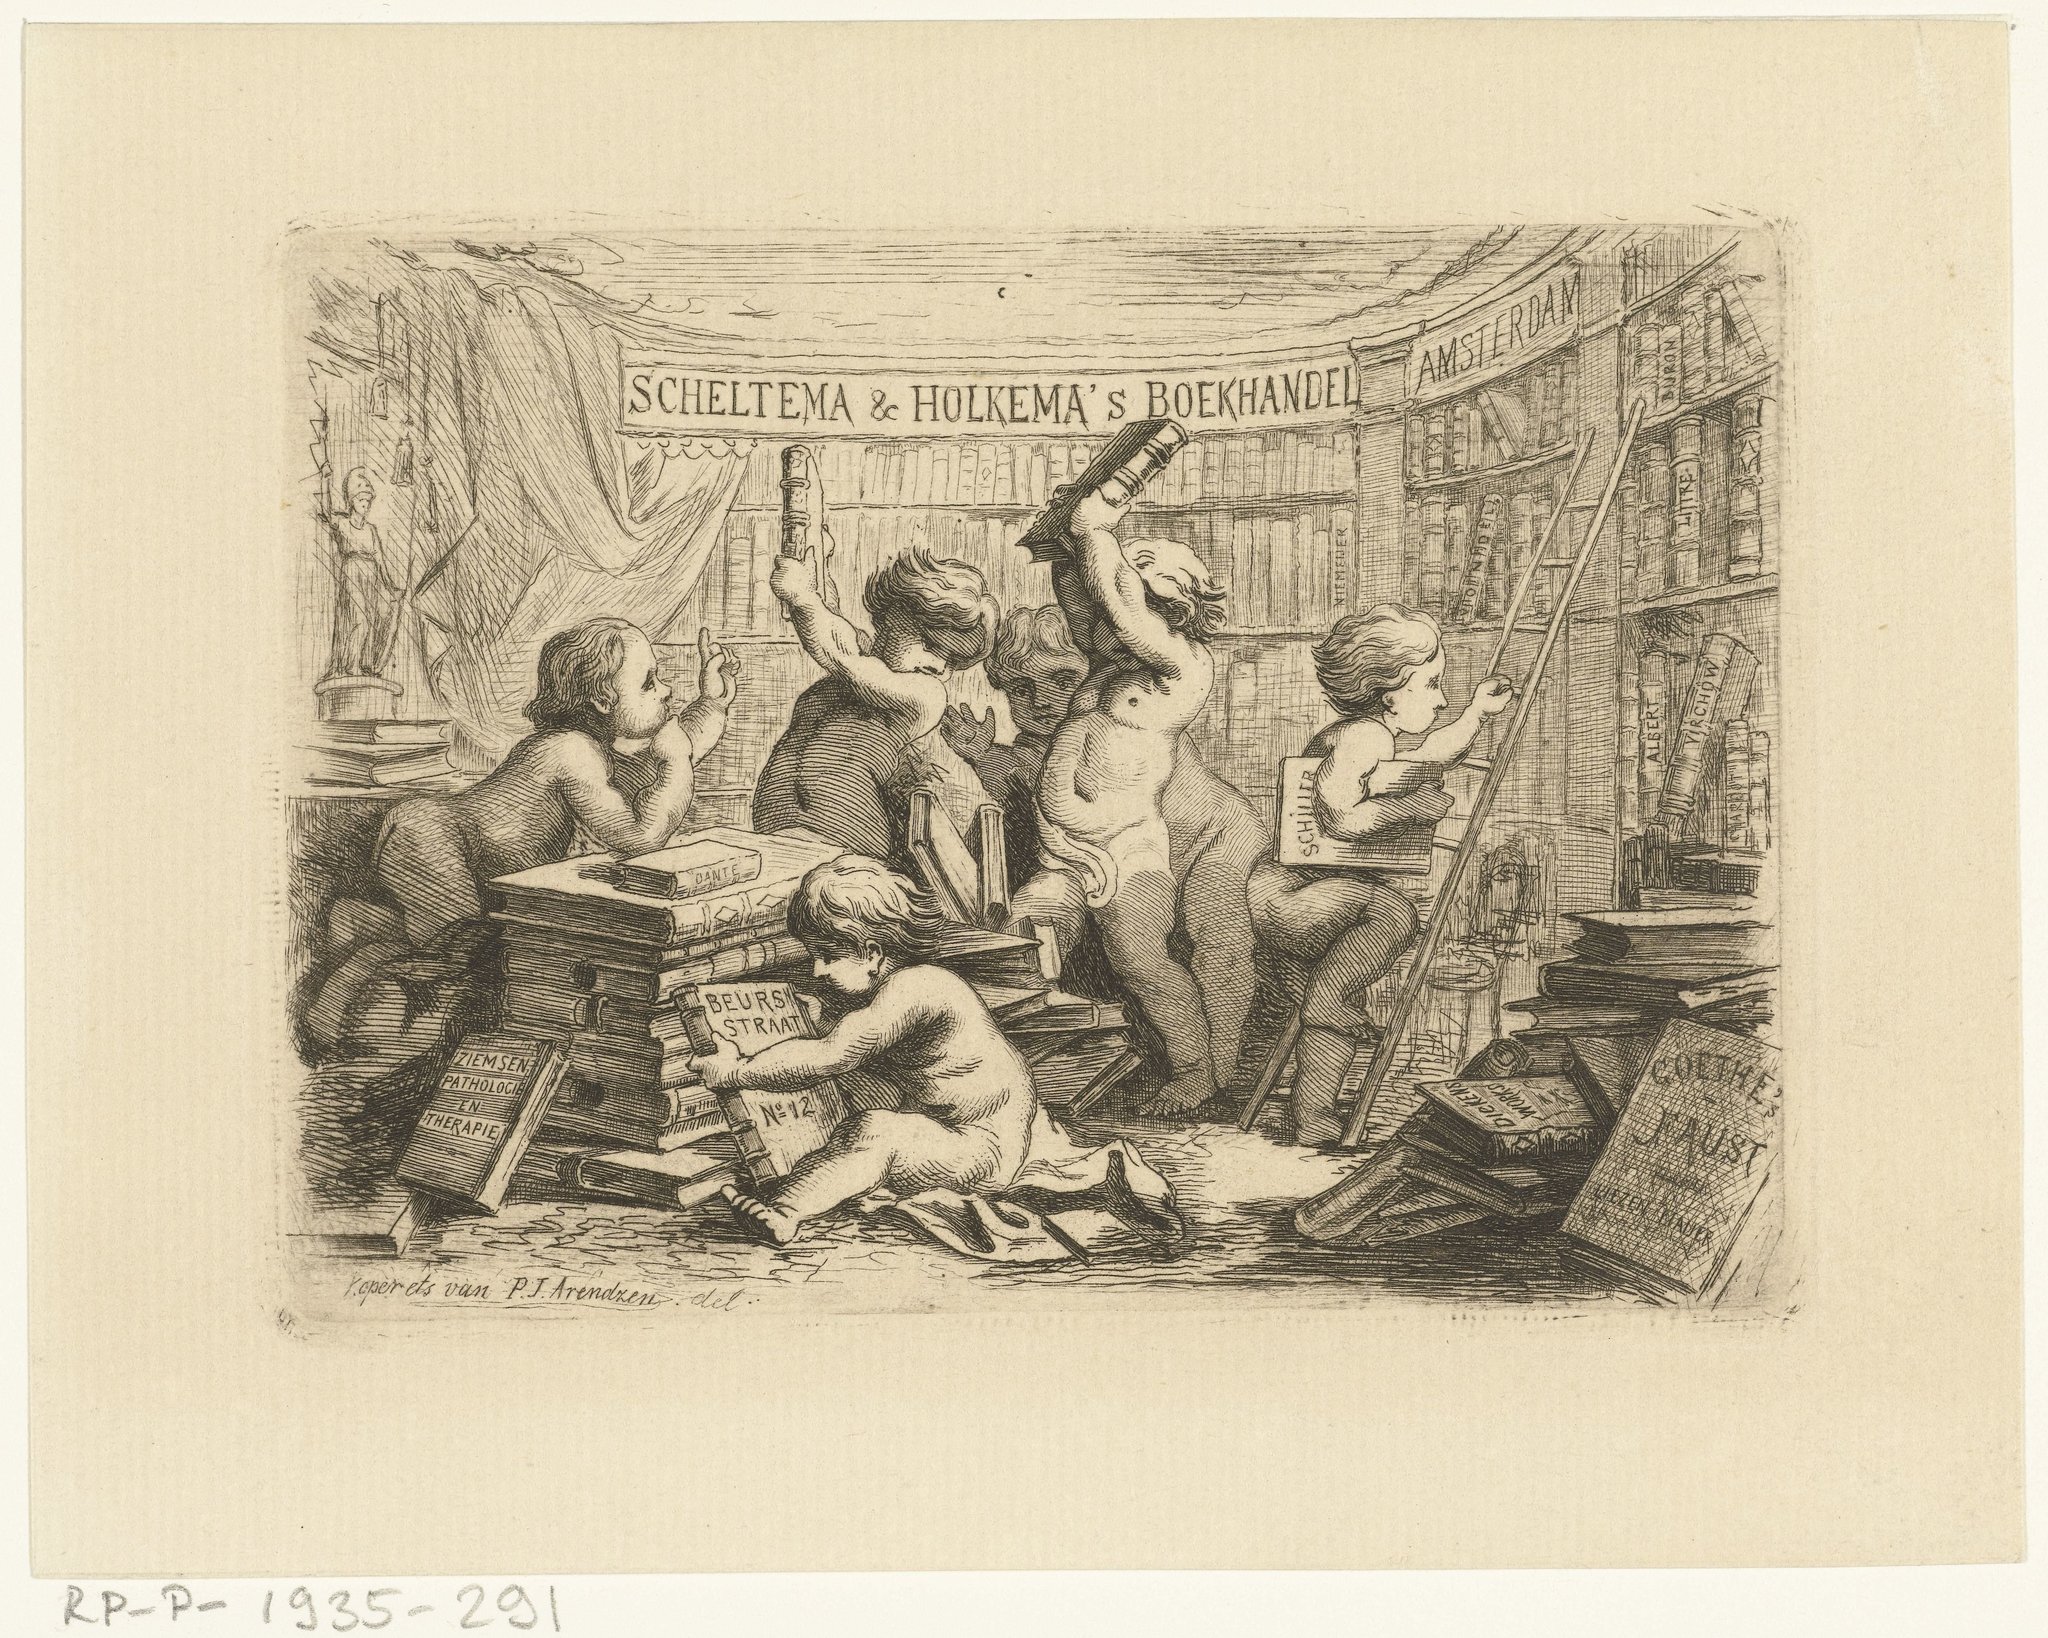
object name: print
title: Adreskaart voor boekhandel Scheltema en Holkema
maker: petrus johannes arendzen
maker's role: draughtsman, print maker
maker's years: 1846-1932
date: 1856-1932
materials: paper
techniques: drypoint, etching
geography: amsterdam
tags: book-shop, bookseller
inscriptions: collector's mark: Lugt 2760, collector's mark: Lugt 2228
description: Zes putti die in een boekwinkel spelen. De naam van de winkel staat op de bovenlijst van de boekenkasten, het adres van de winkel op de band van een boek.